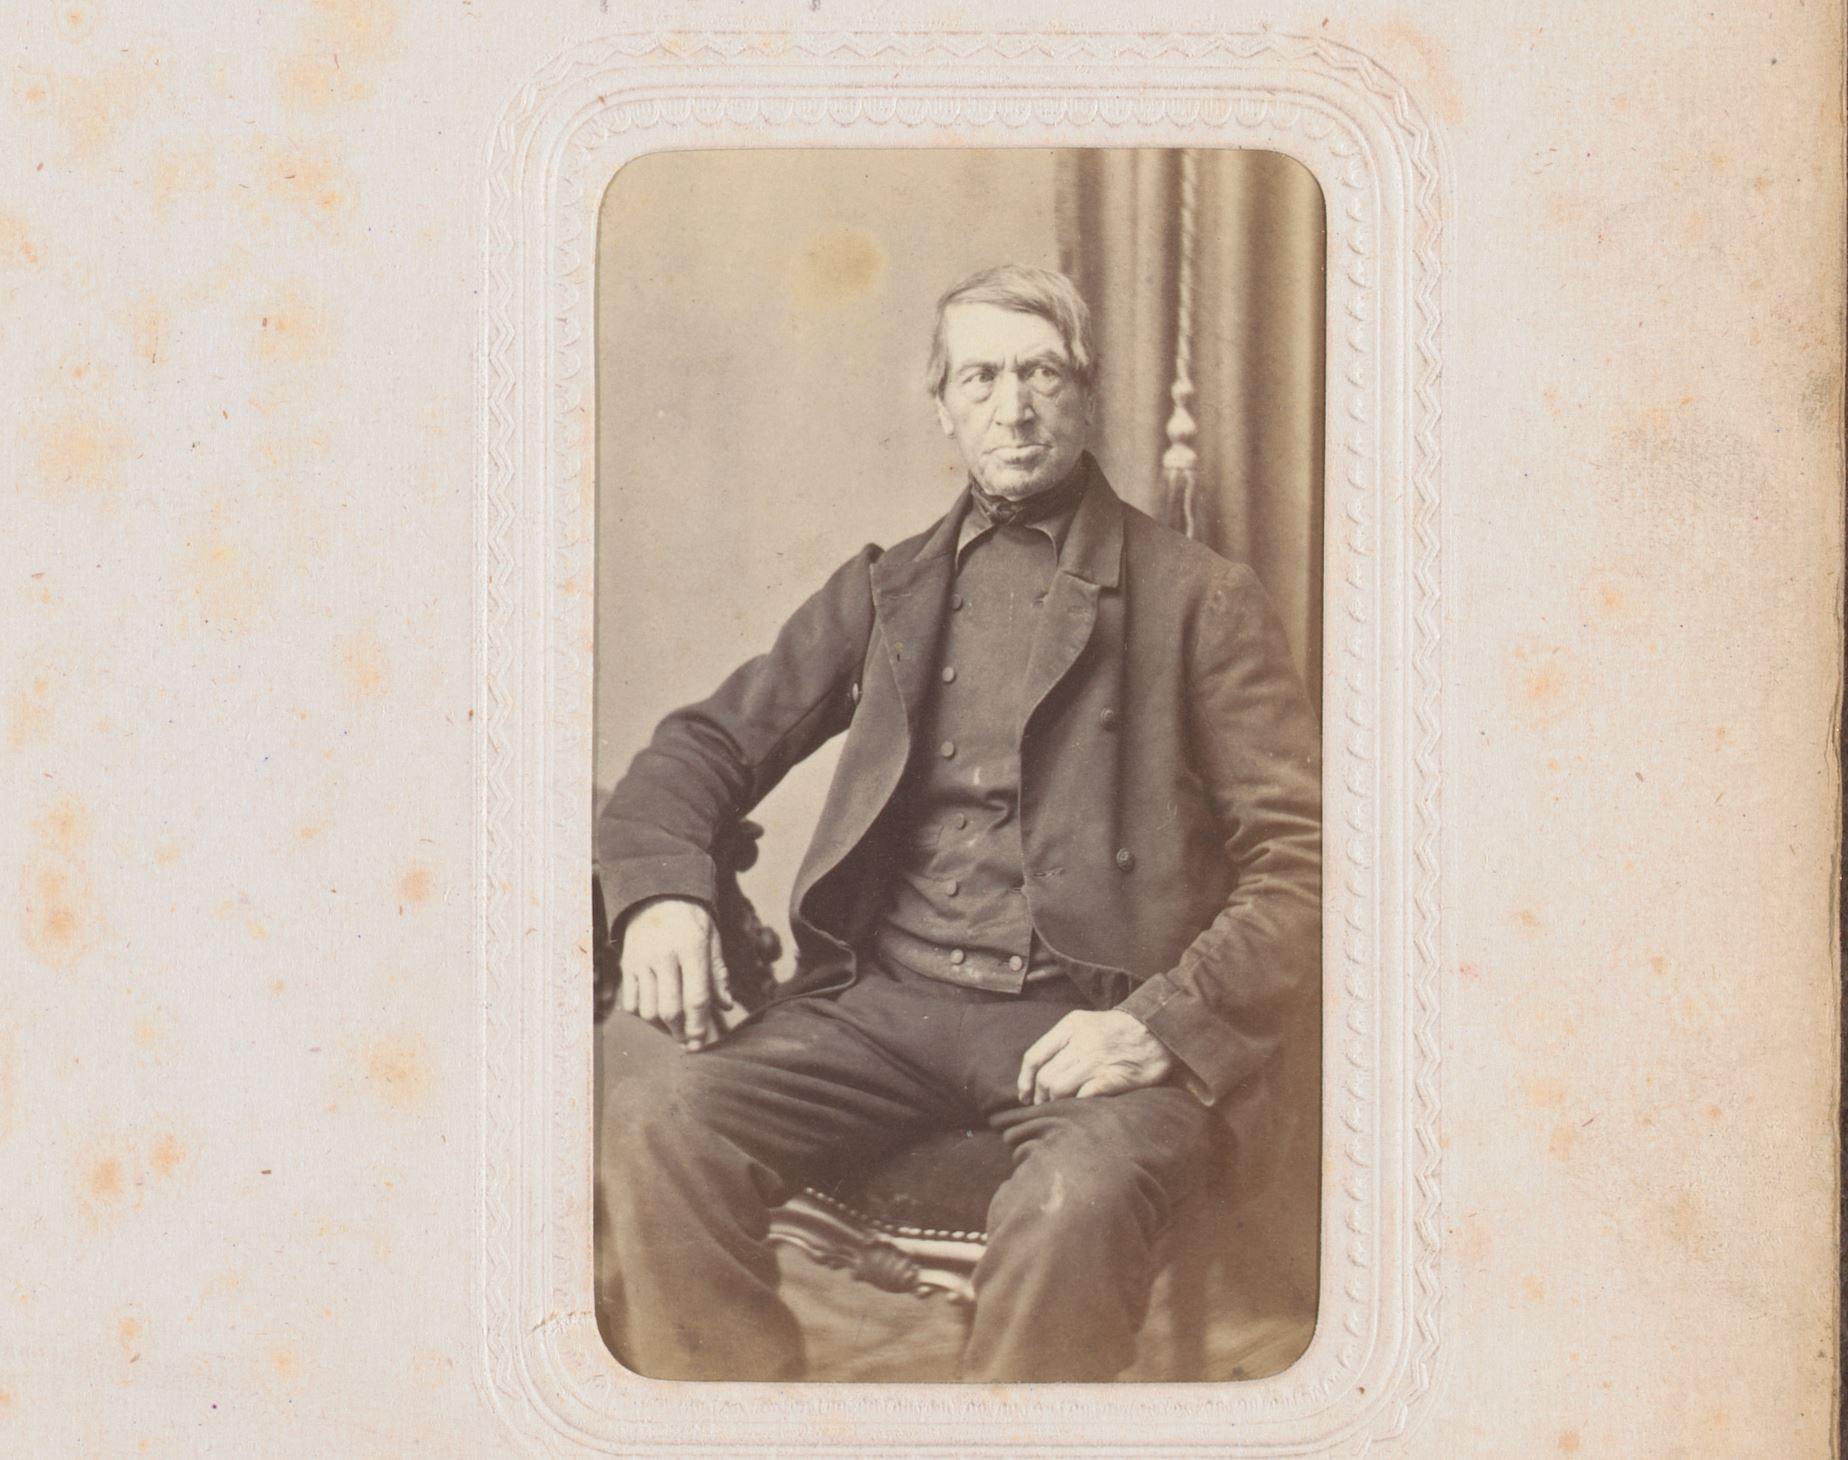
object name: photograph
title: Portret van een zittende man, aangeduid als Kooymans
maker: kornelis willem schorteldoek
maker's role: boekbinder, fotograaf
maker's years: 1800-1885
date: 1855-1885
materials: cardboard, photographic support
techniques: albumen print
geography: gorinchem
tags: sitting figure, historical persons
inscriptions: inscription: ‘SCHORTELDOEK/ PHOTOGRAAF/ GORINCHEM./ Groote Markt’, name: ‘Kooymans’